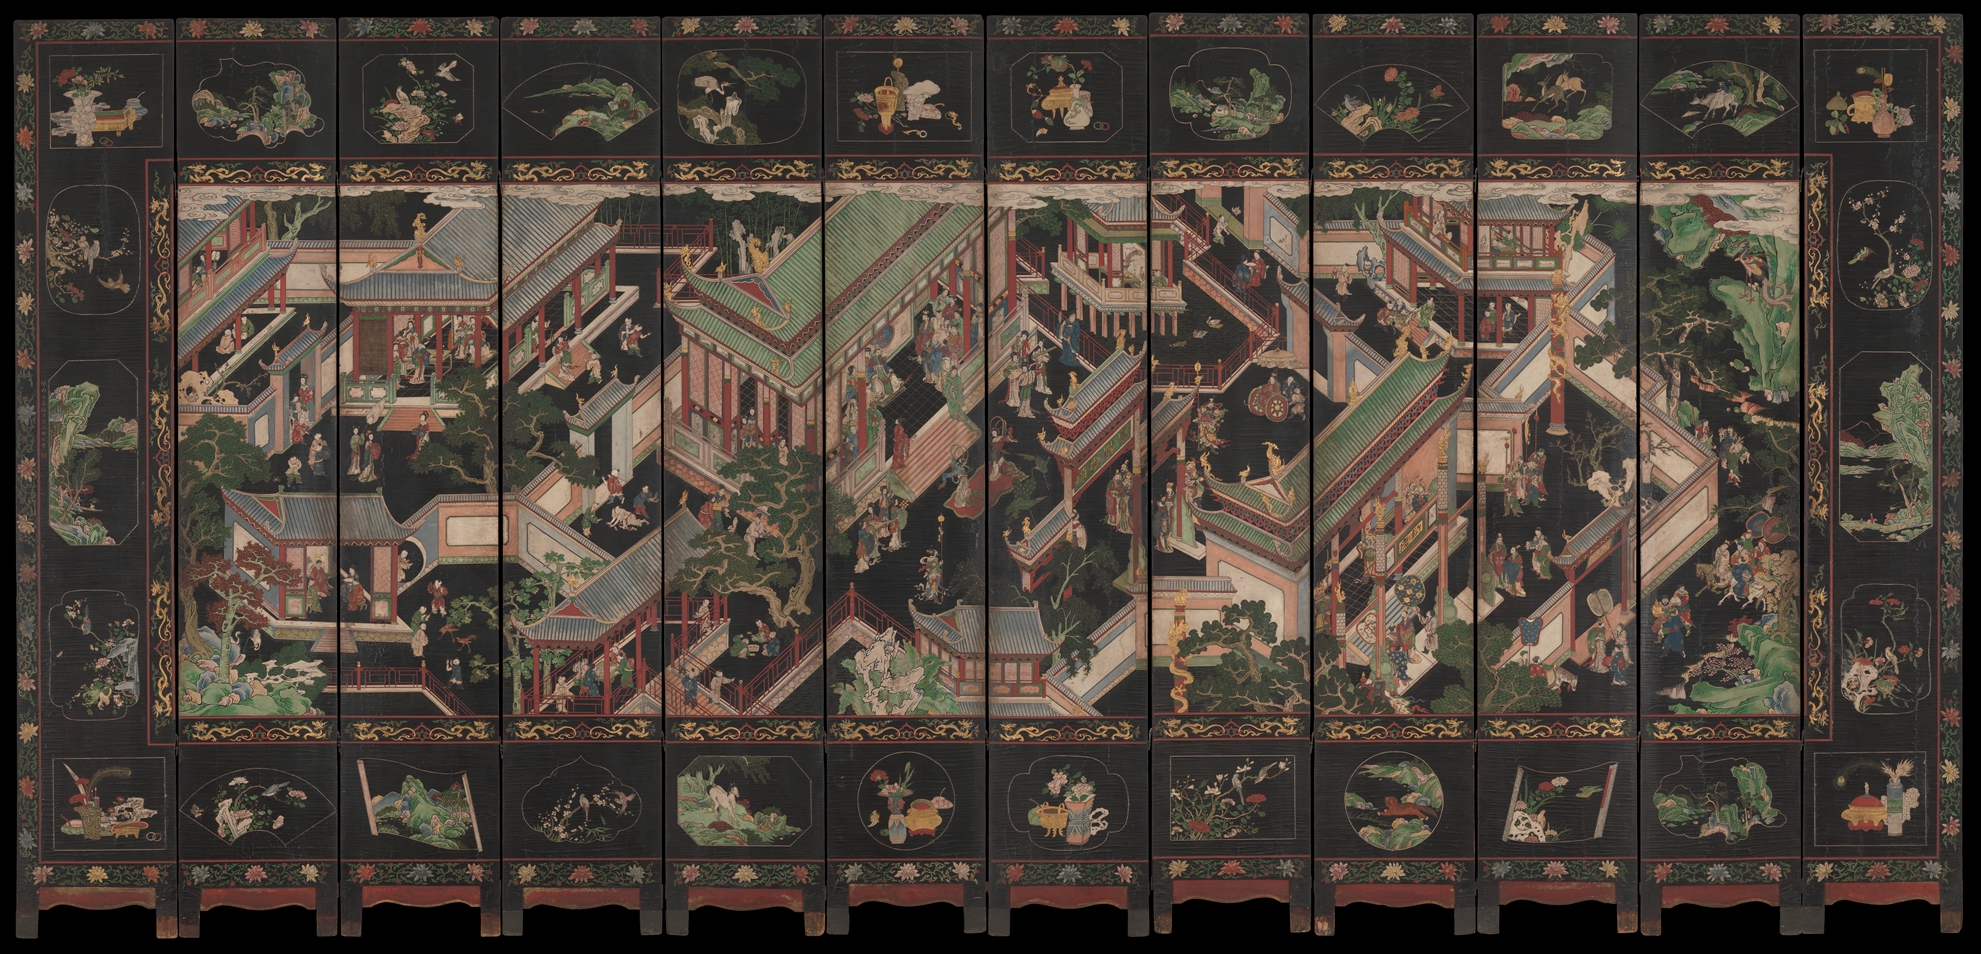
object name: screen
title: Palace Scene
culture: chinese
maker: feng langgong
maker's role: artist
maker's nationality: chinese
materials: gilt, panel, wood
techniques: lacquer, painting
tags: palaces